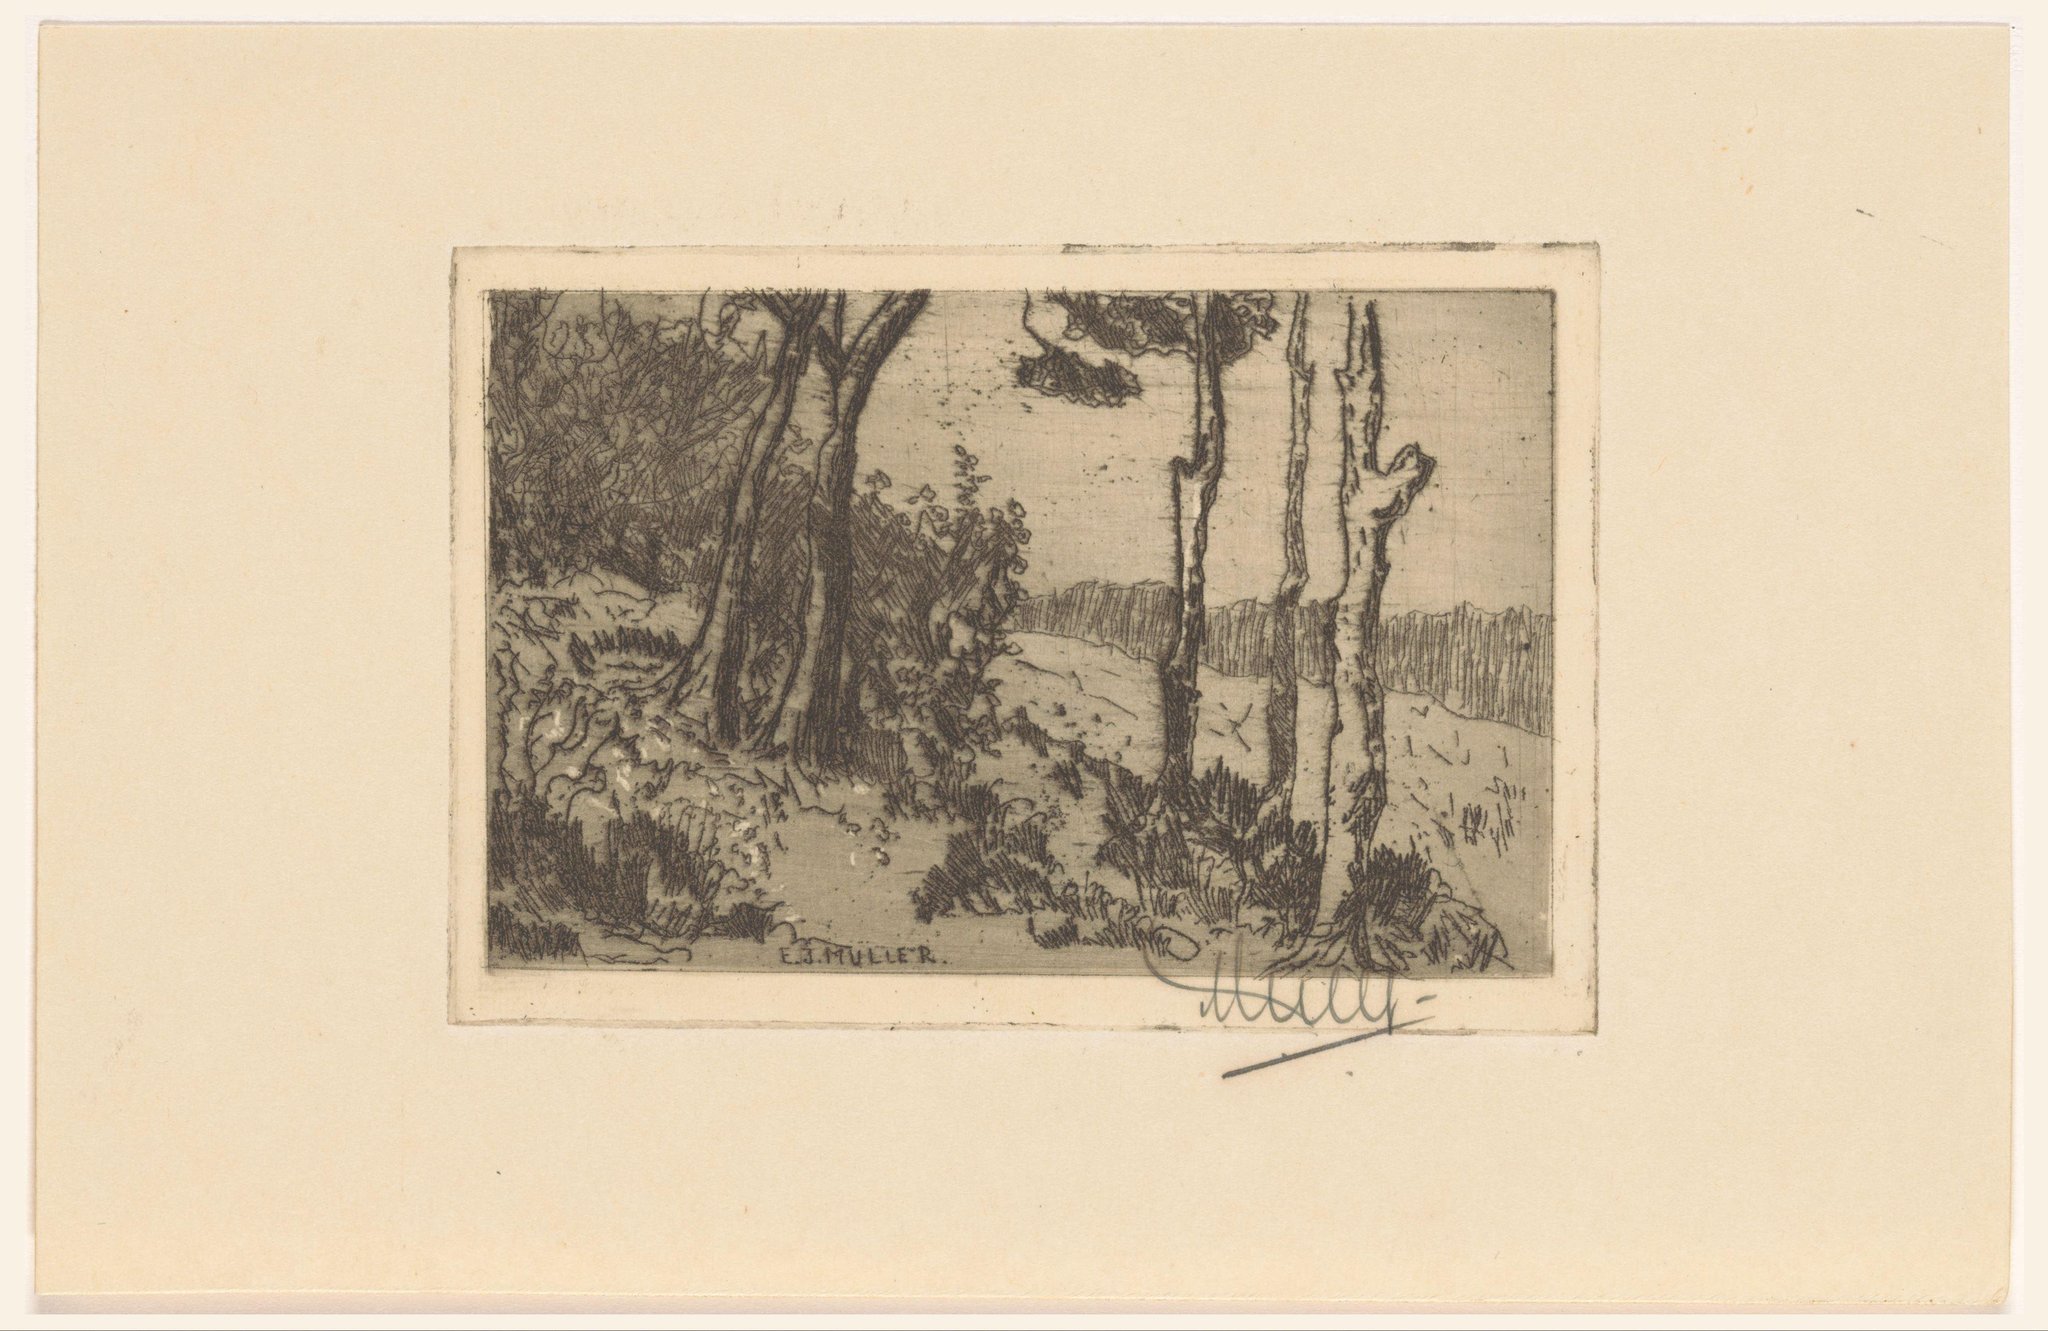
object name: print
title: Bosrand op heuvel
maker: evert jan muller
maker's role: print maker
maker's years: 1887-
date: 1897-1938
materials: paper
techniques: etching, intaglio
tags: fringe, edge of the wood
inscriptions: collector's mark: Lugt 2760, collector's mark: Lugt 2228